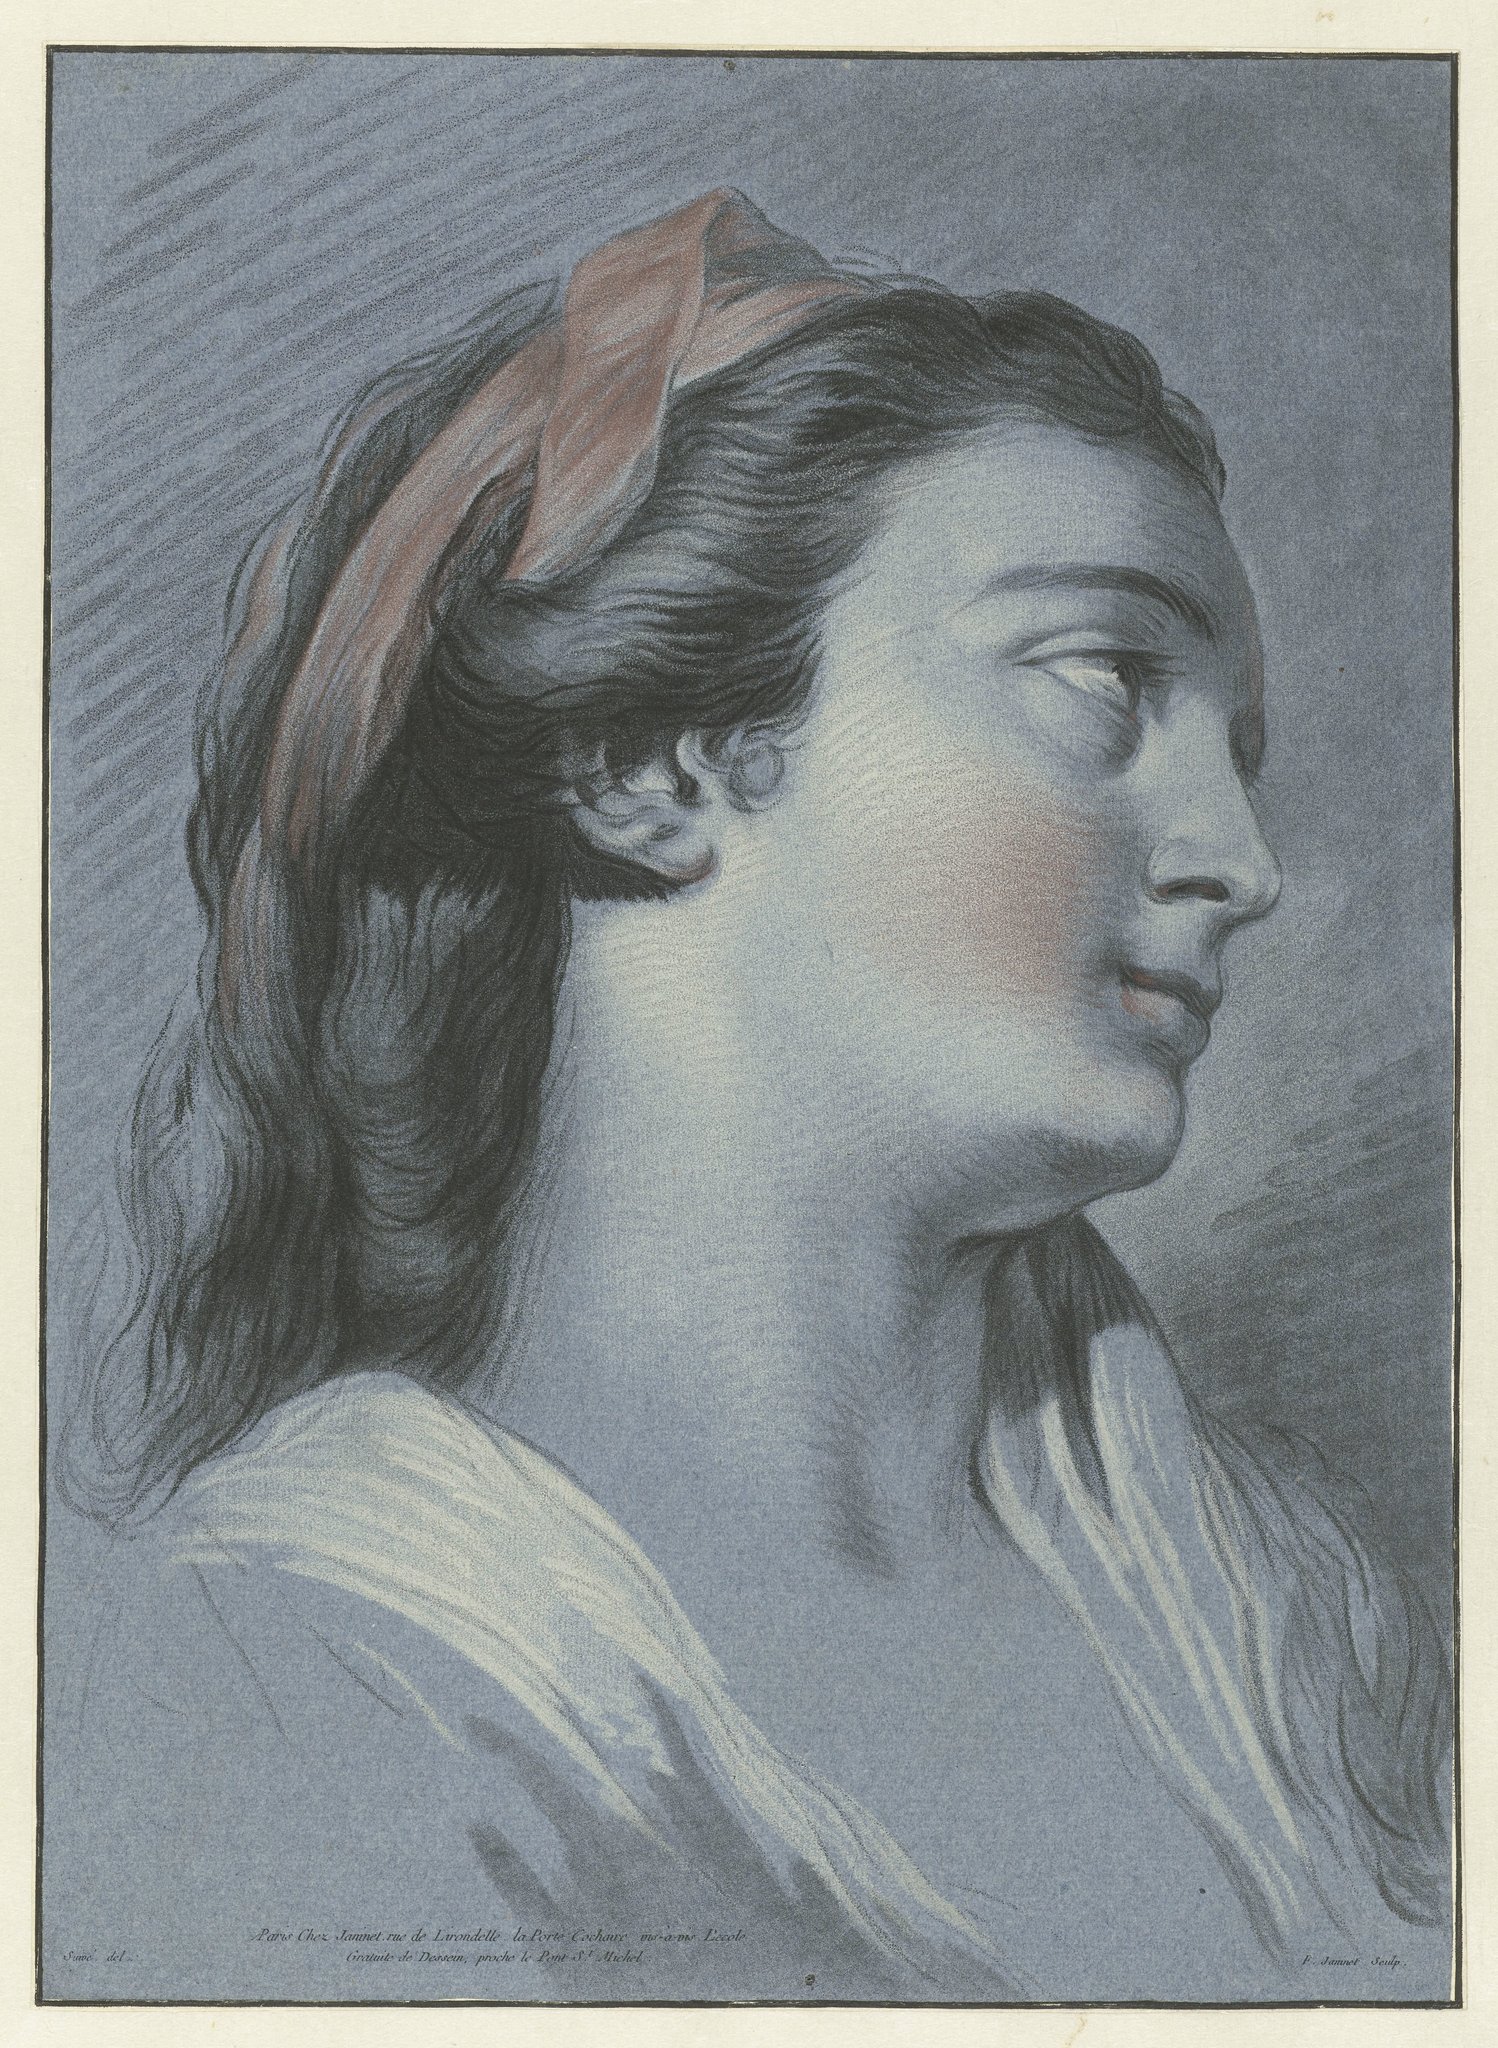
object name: print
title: Tête de femme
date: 1762-1814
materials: paper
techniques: printmaking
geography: france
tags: adolescent, young woman, maiden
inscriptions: collector's mark: Lugt 2228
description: Hoofd van een jonge vrouw met een rood lint in haar haren.